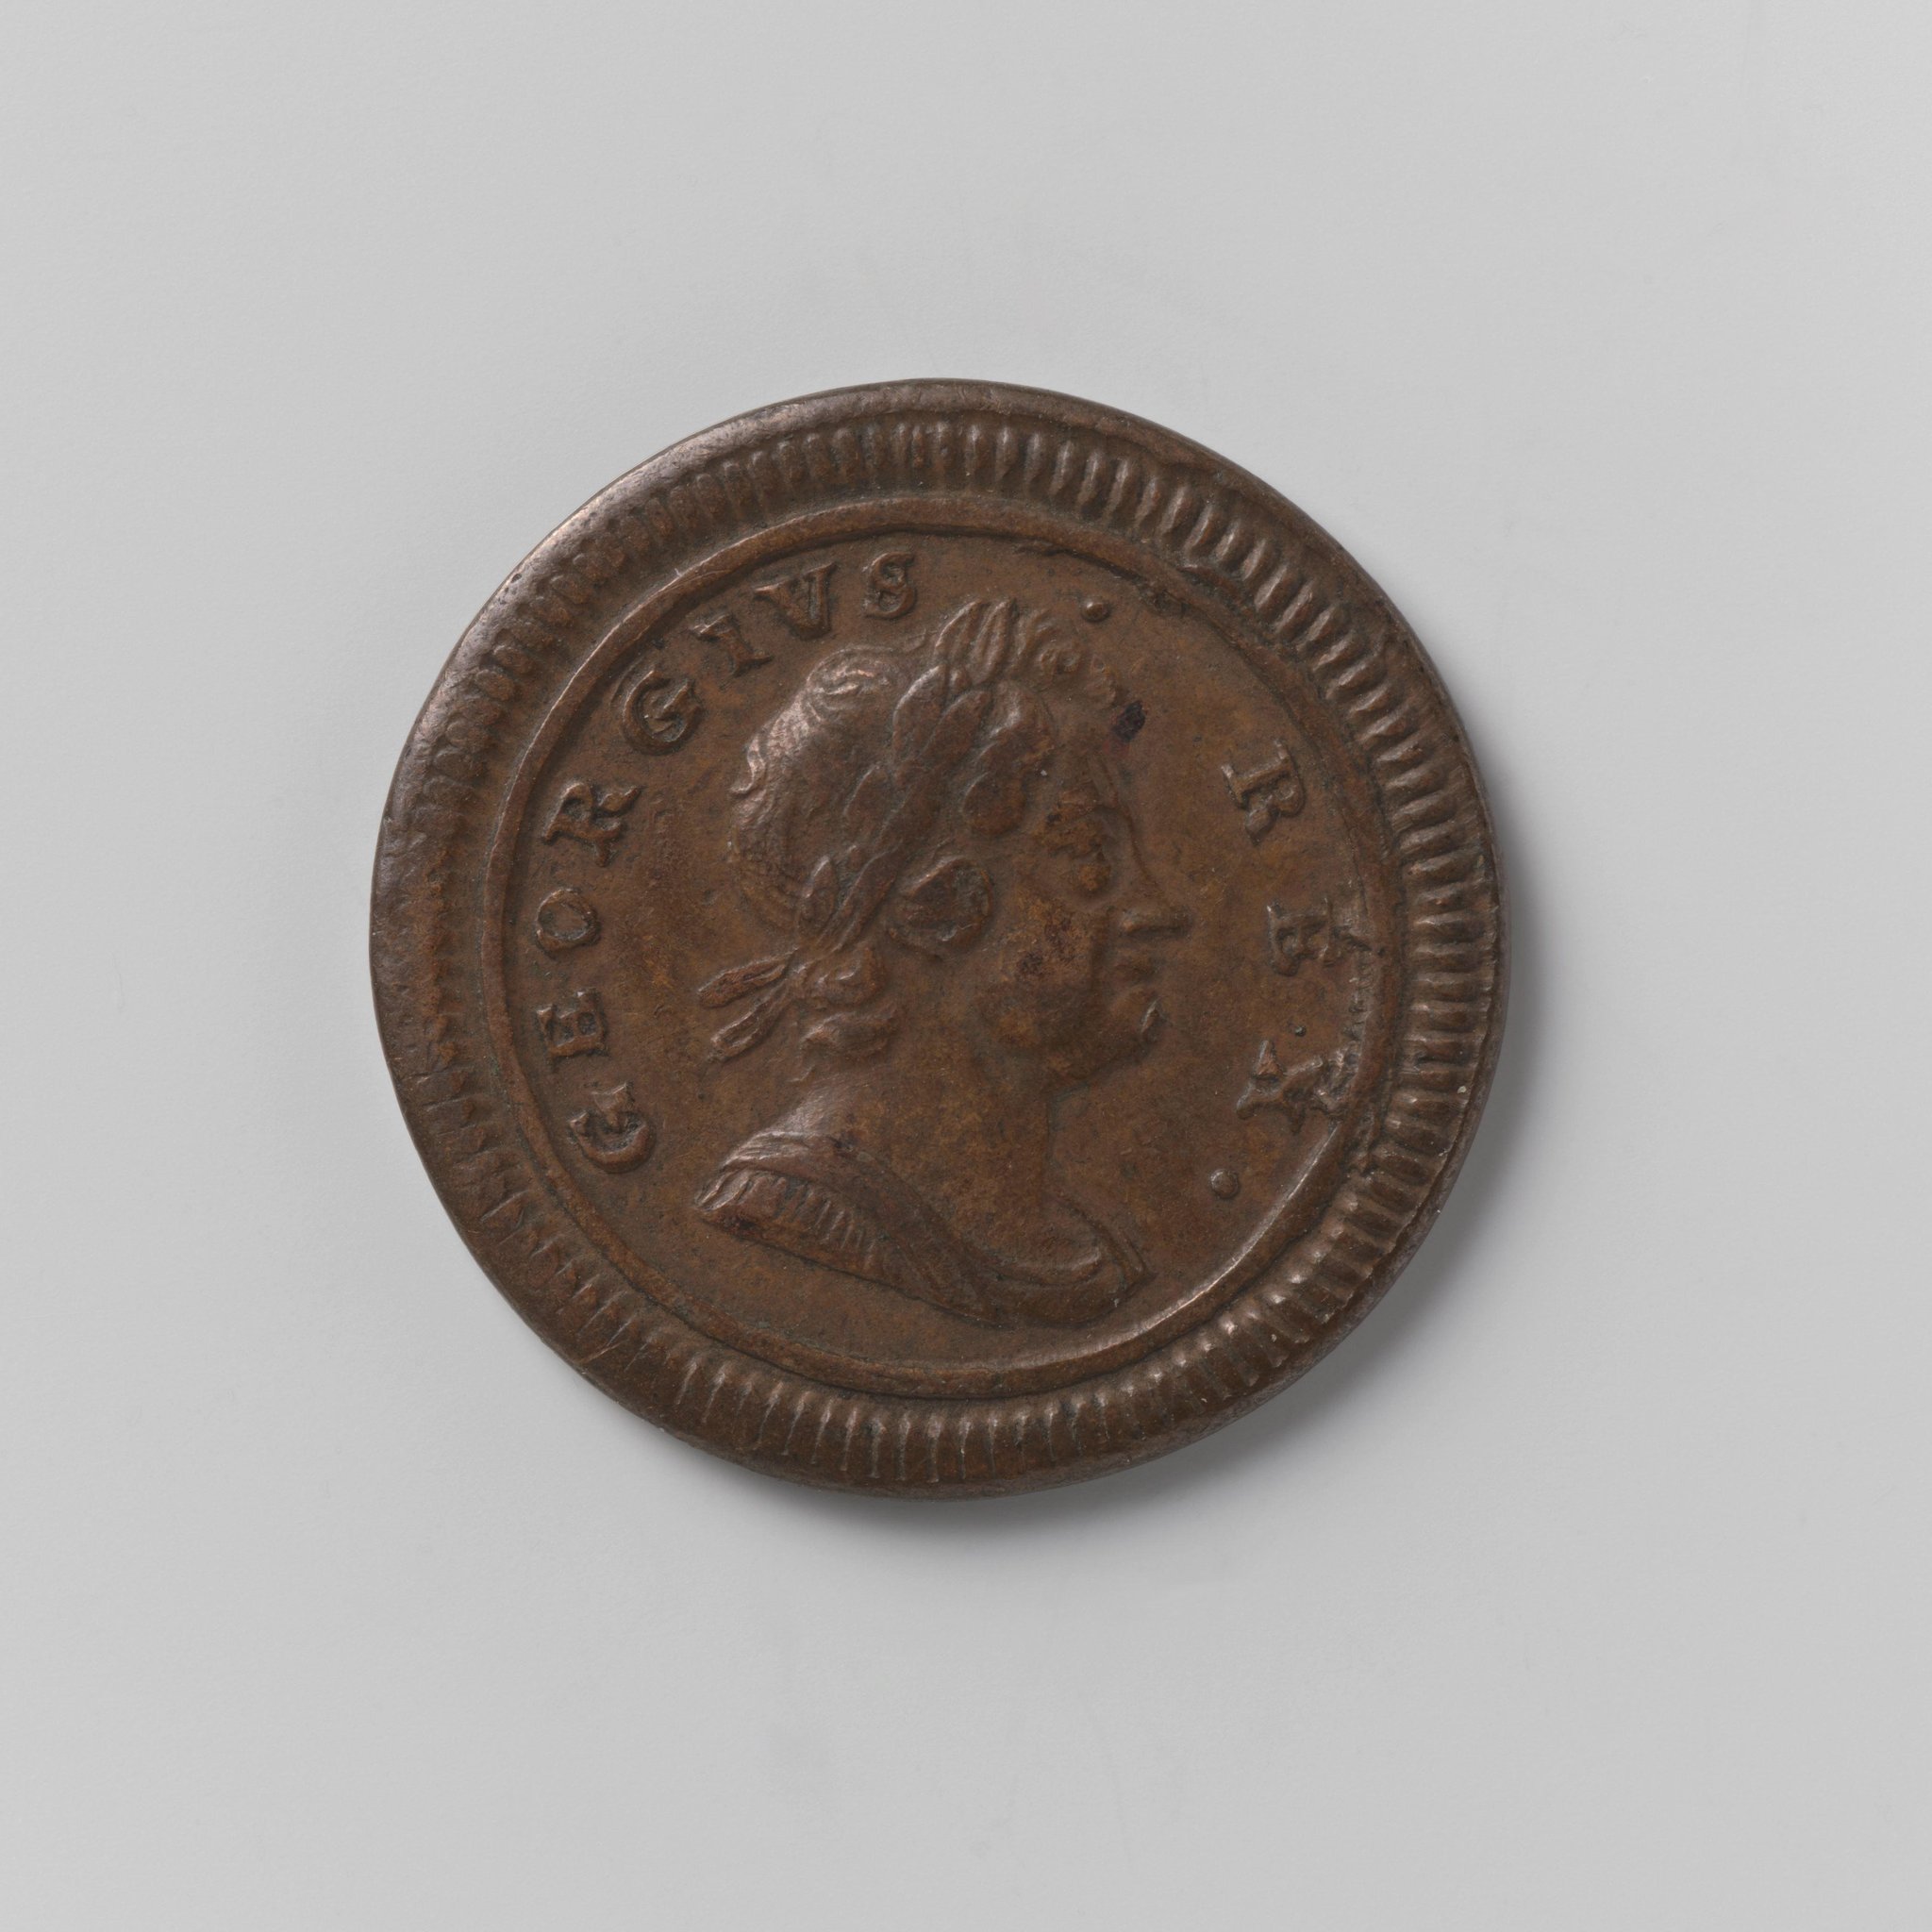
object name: coin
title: Farthing uit Engeland van George I, 1719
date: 1719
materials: copper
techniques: striking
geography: london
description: Koperen munt. Voorzijde: gelauwerd borstbeeld van de koning naar rechts. Keerzijde: op rots, waartegen schild geplaatst, gezeten Brittannia met drietand en tak, naar links. jaartal in afsnede.